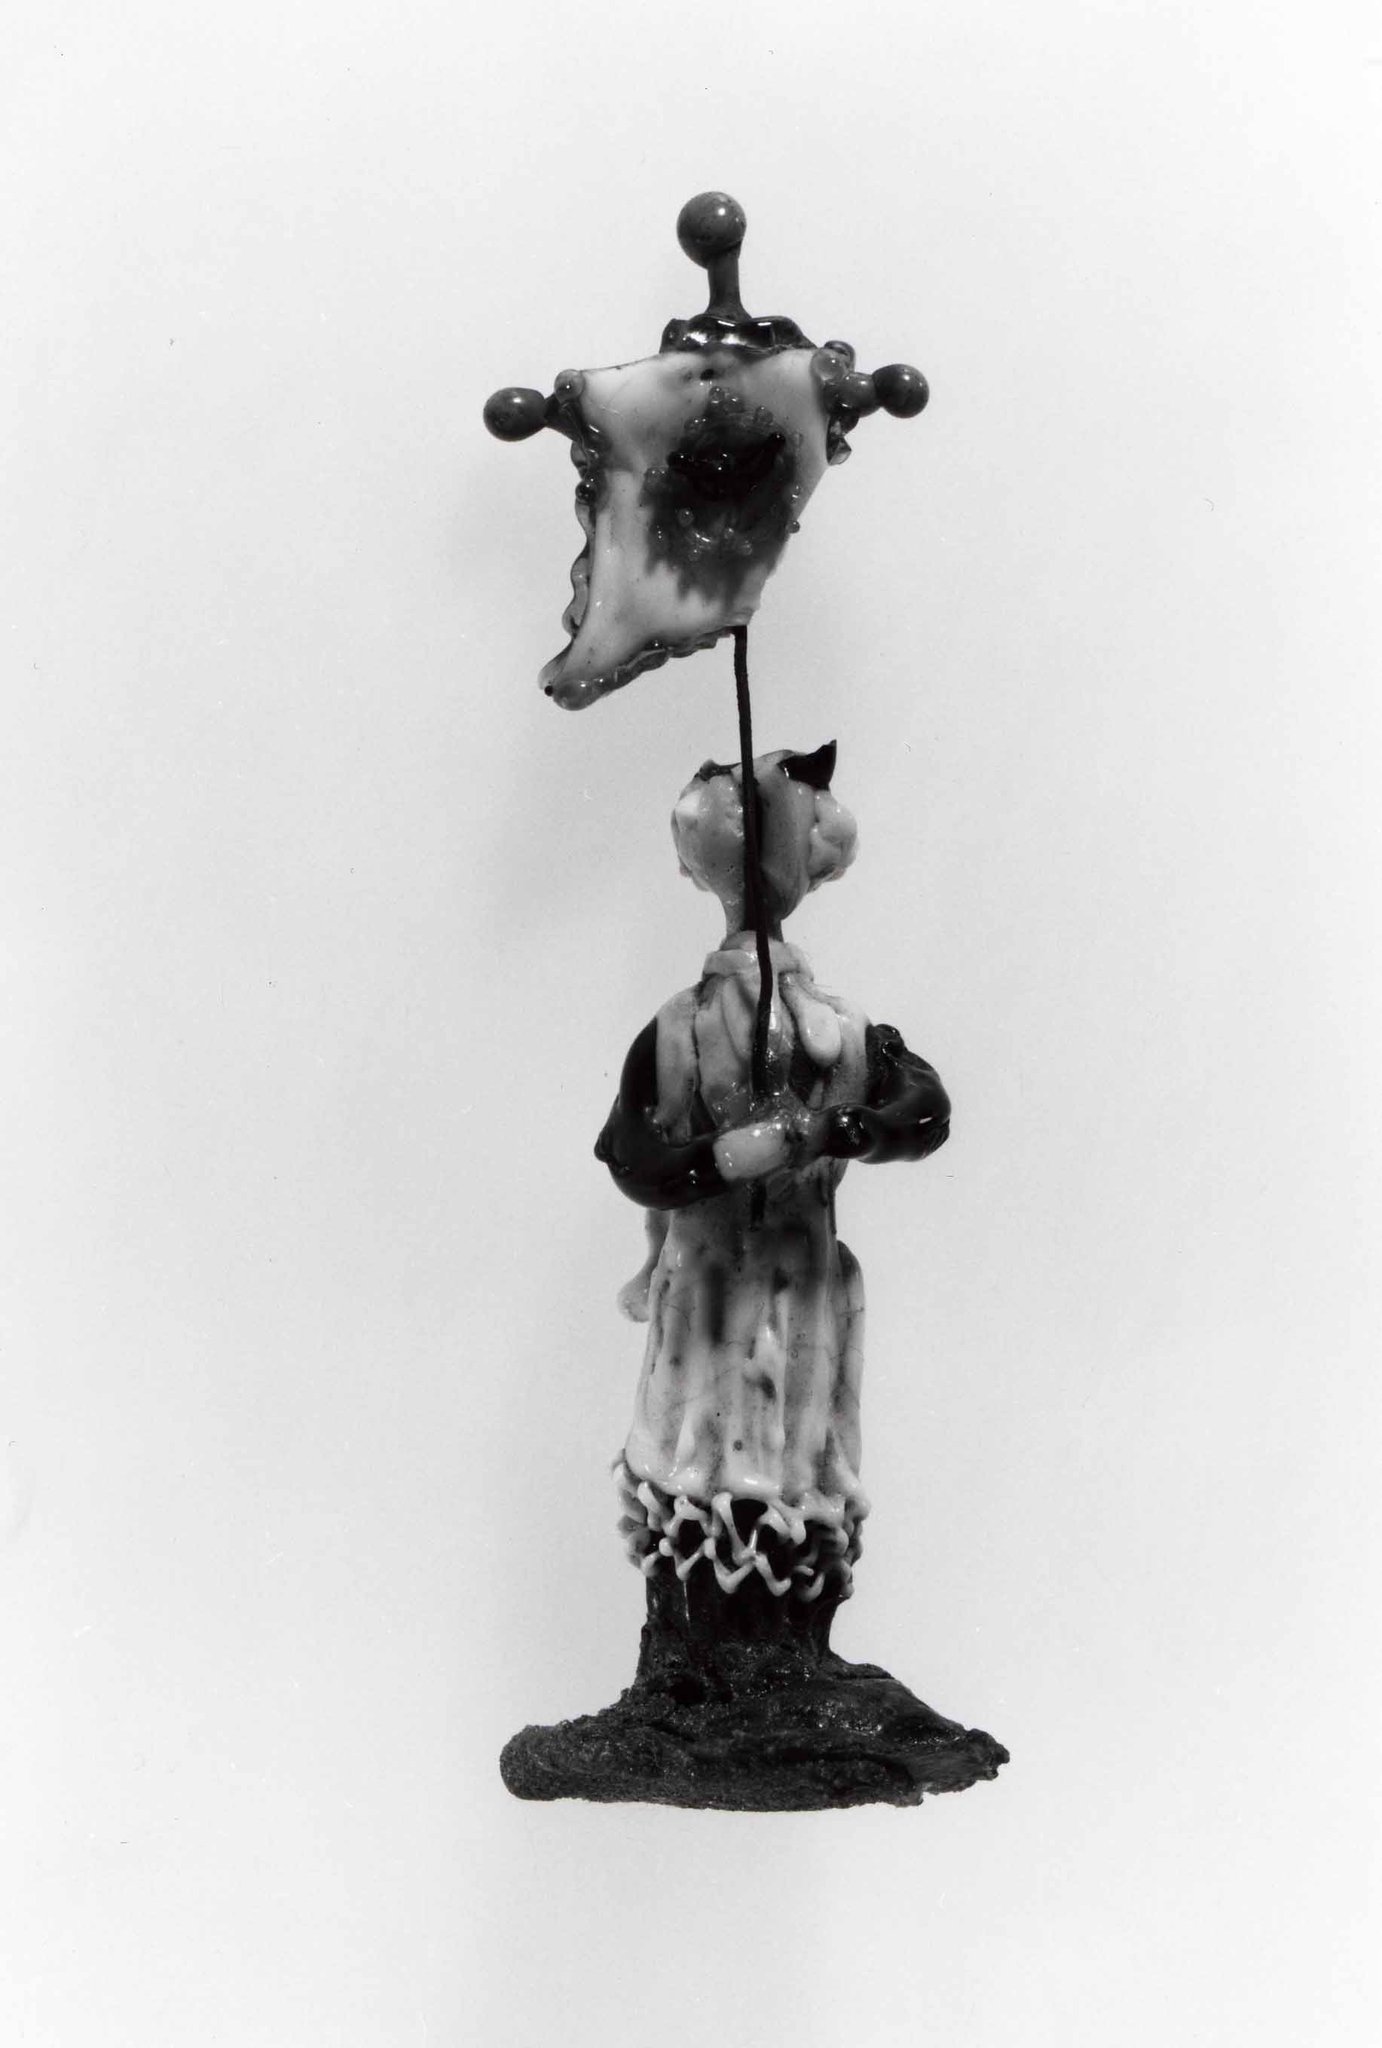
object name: figurine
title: An Acolyte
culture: french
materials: copper, glass, iron, metal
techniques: lampwork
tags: human figures